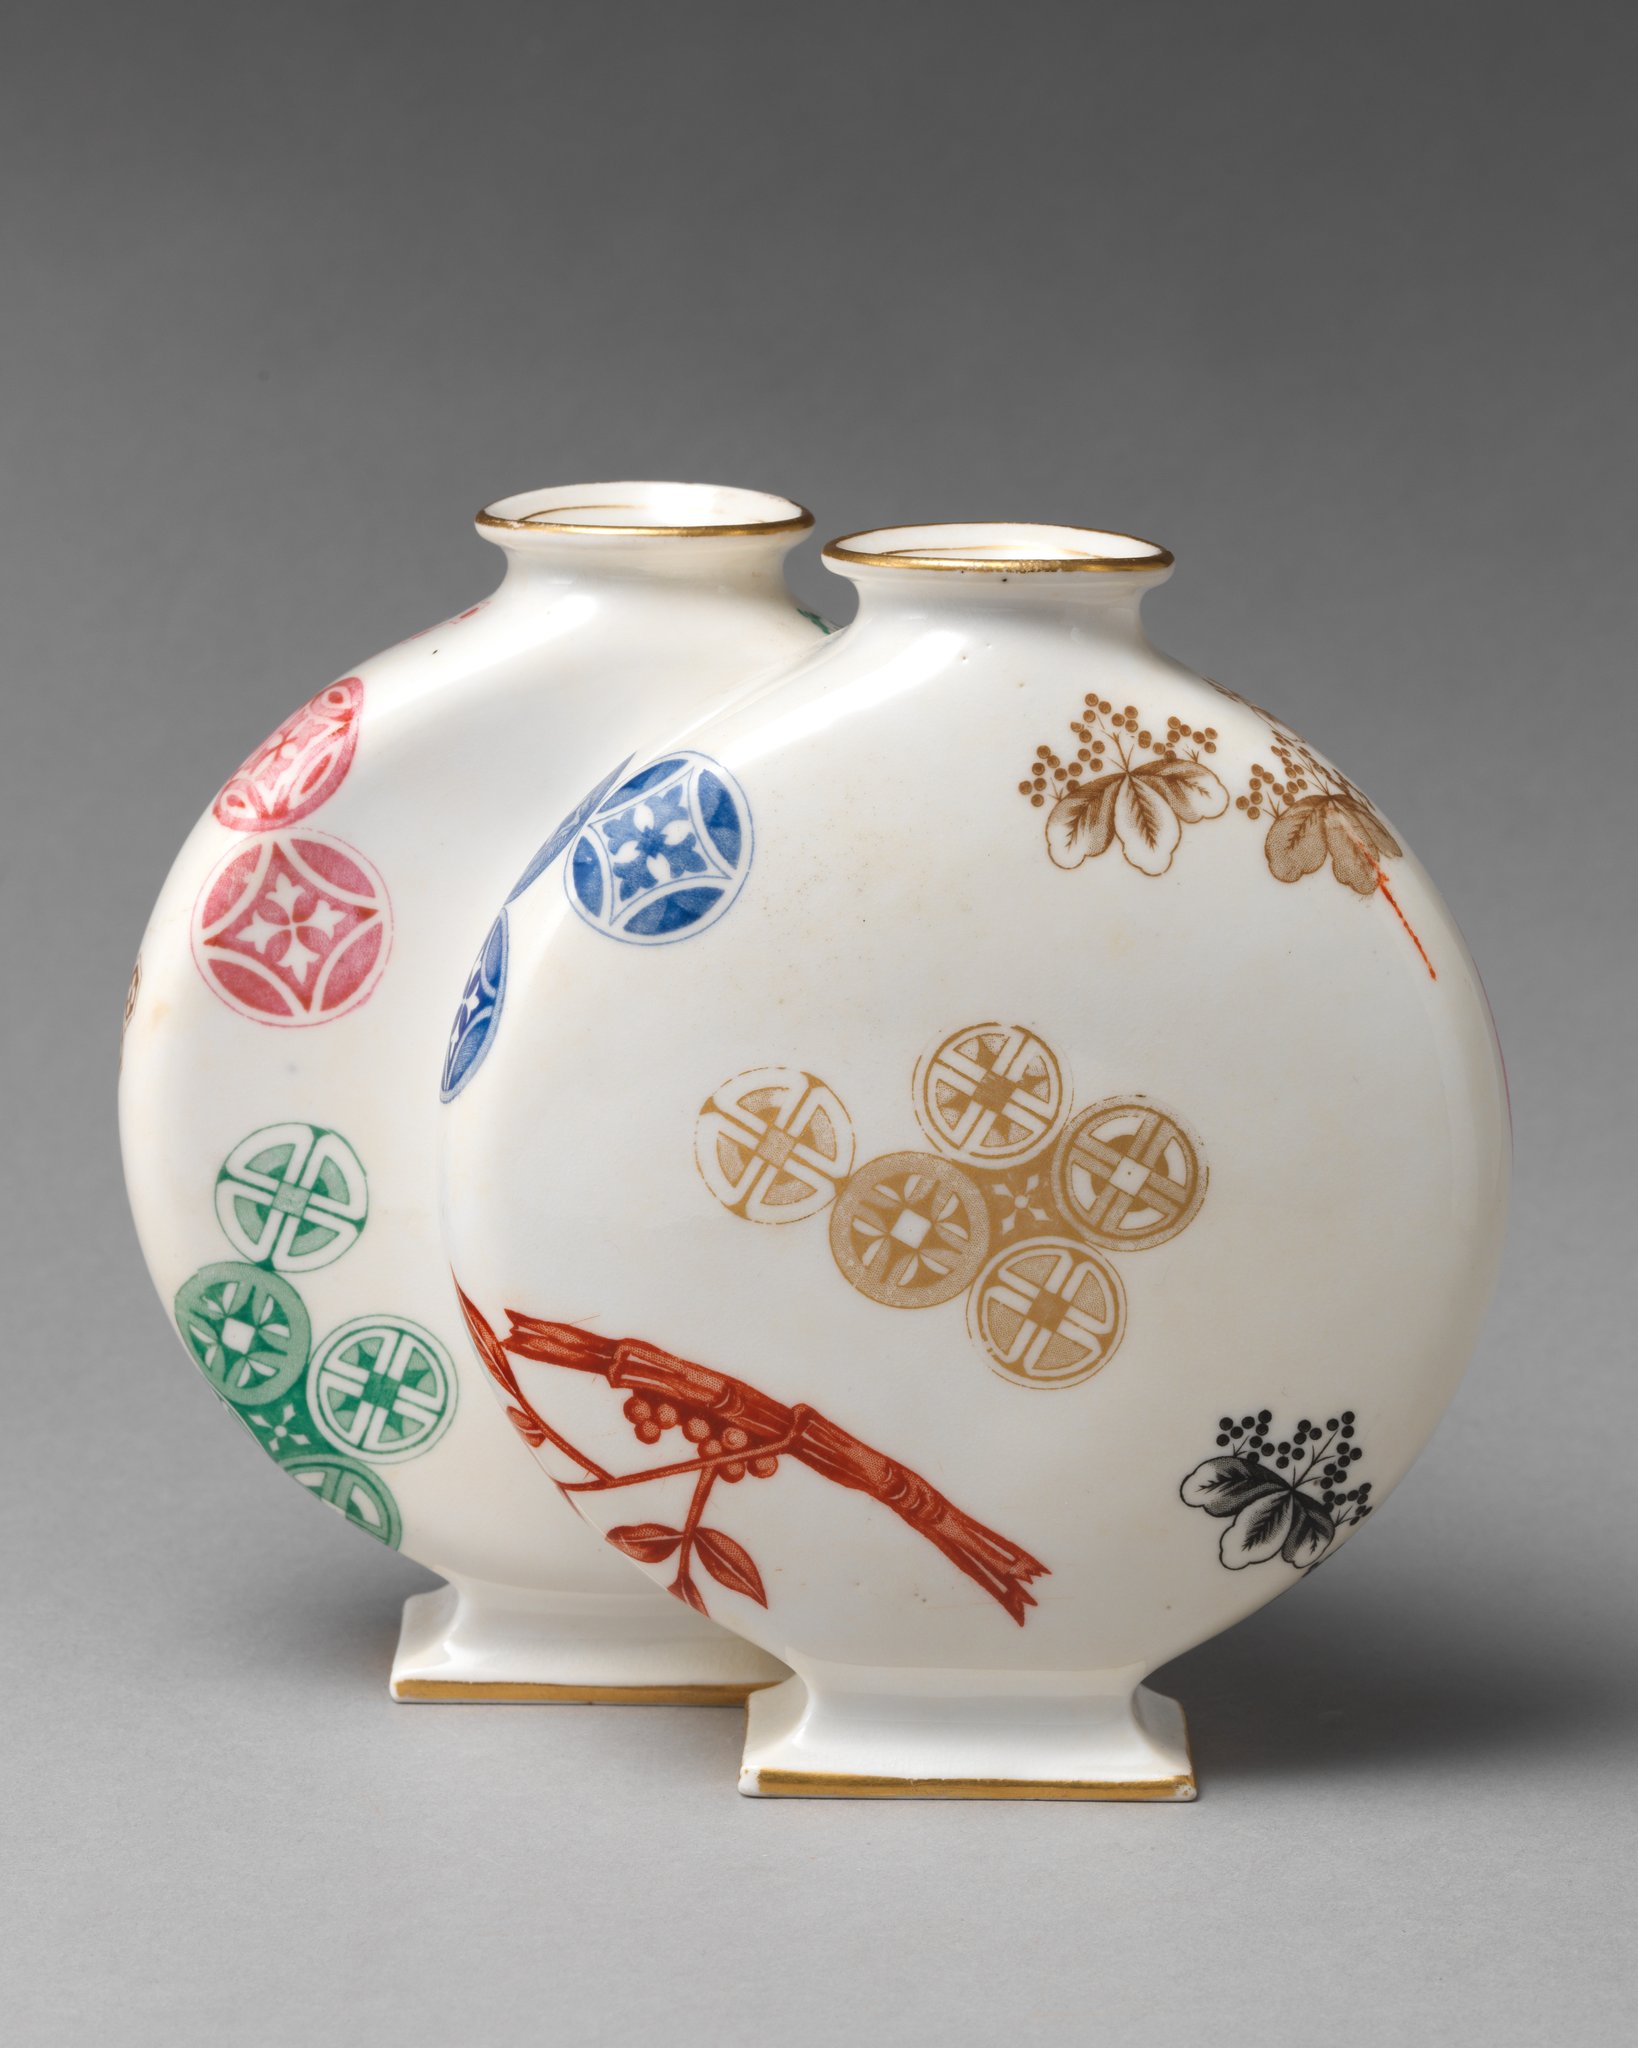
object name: moon flask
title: Double moon flask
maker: worcester factory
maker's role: maker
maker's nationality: british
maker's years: 1751-2008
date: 1870-1879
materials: bone china